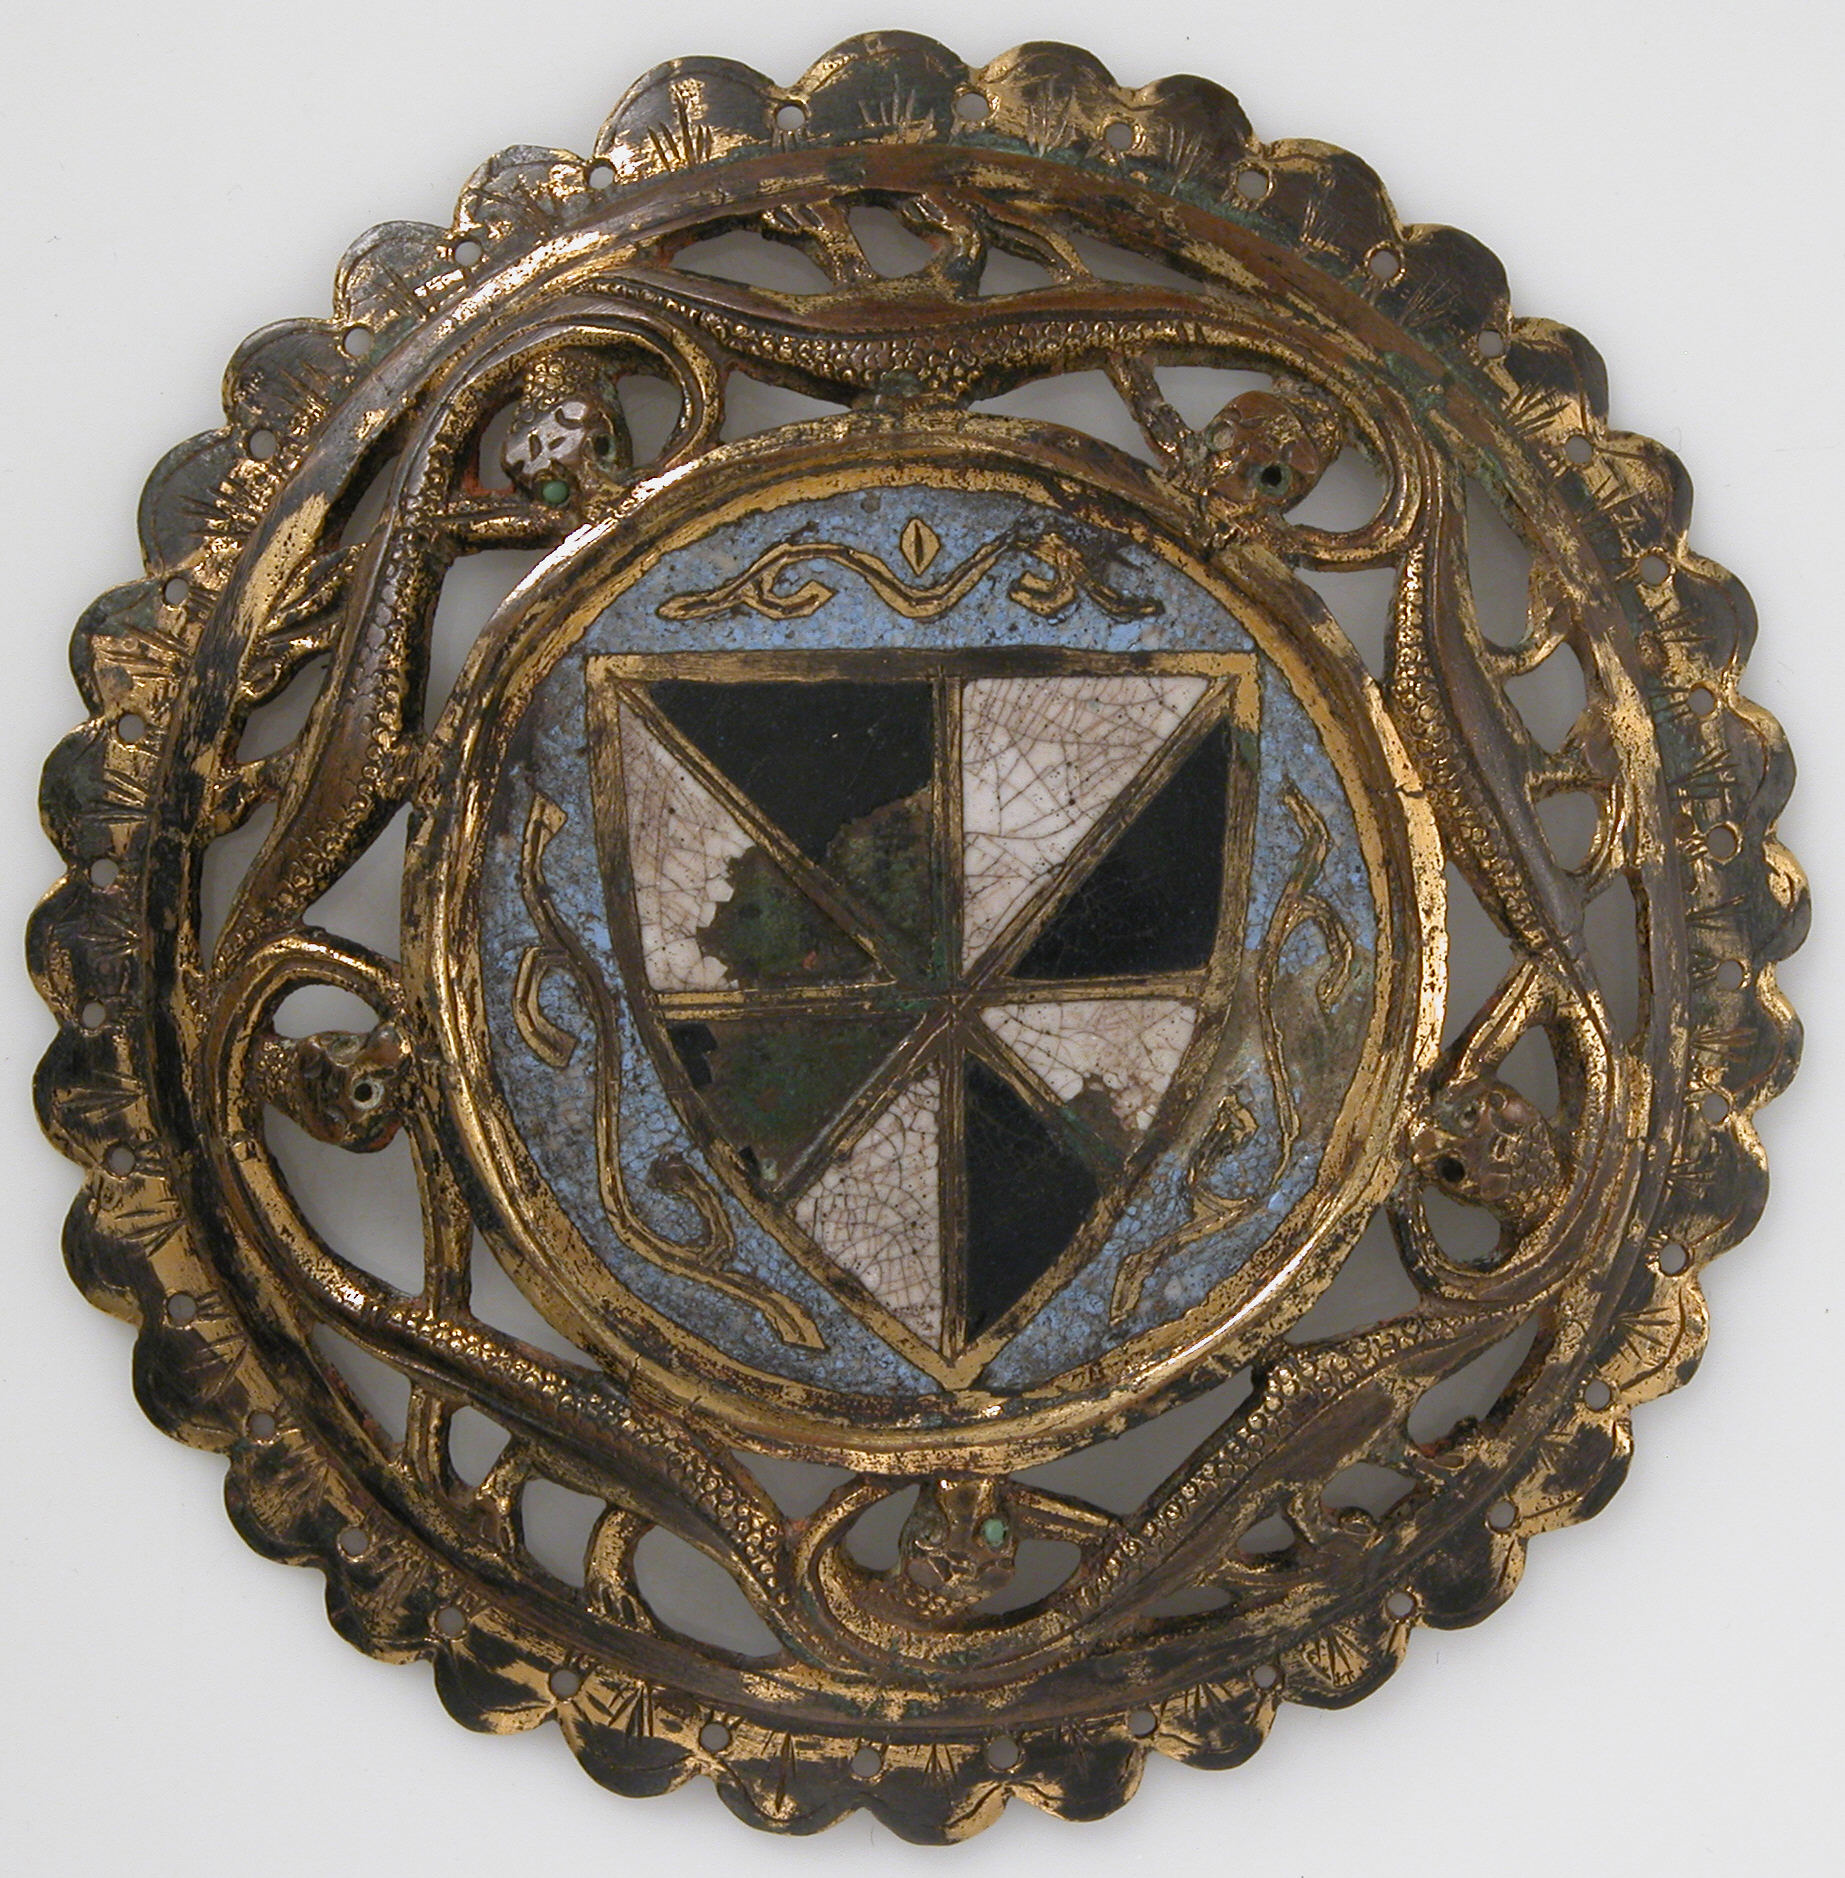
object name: roundel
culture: french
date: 1301-1400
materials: gilt copper, enamel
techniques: enamel